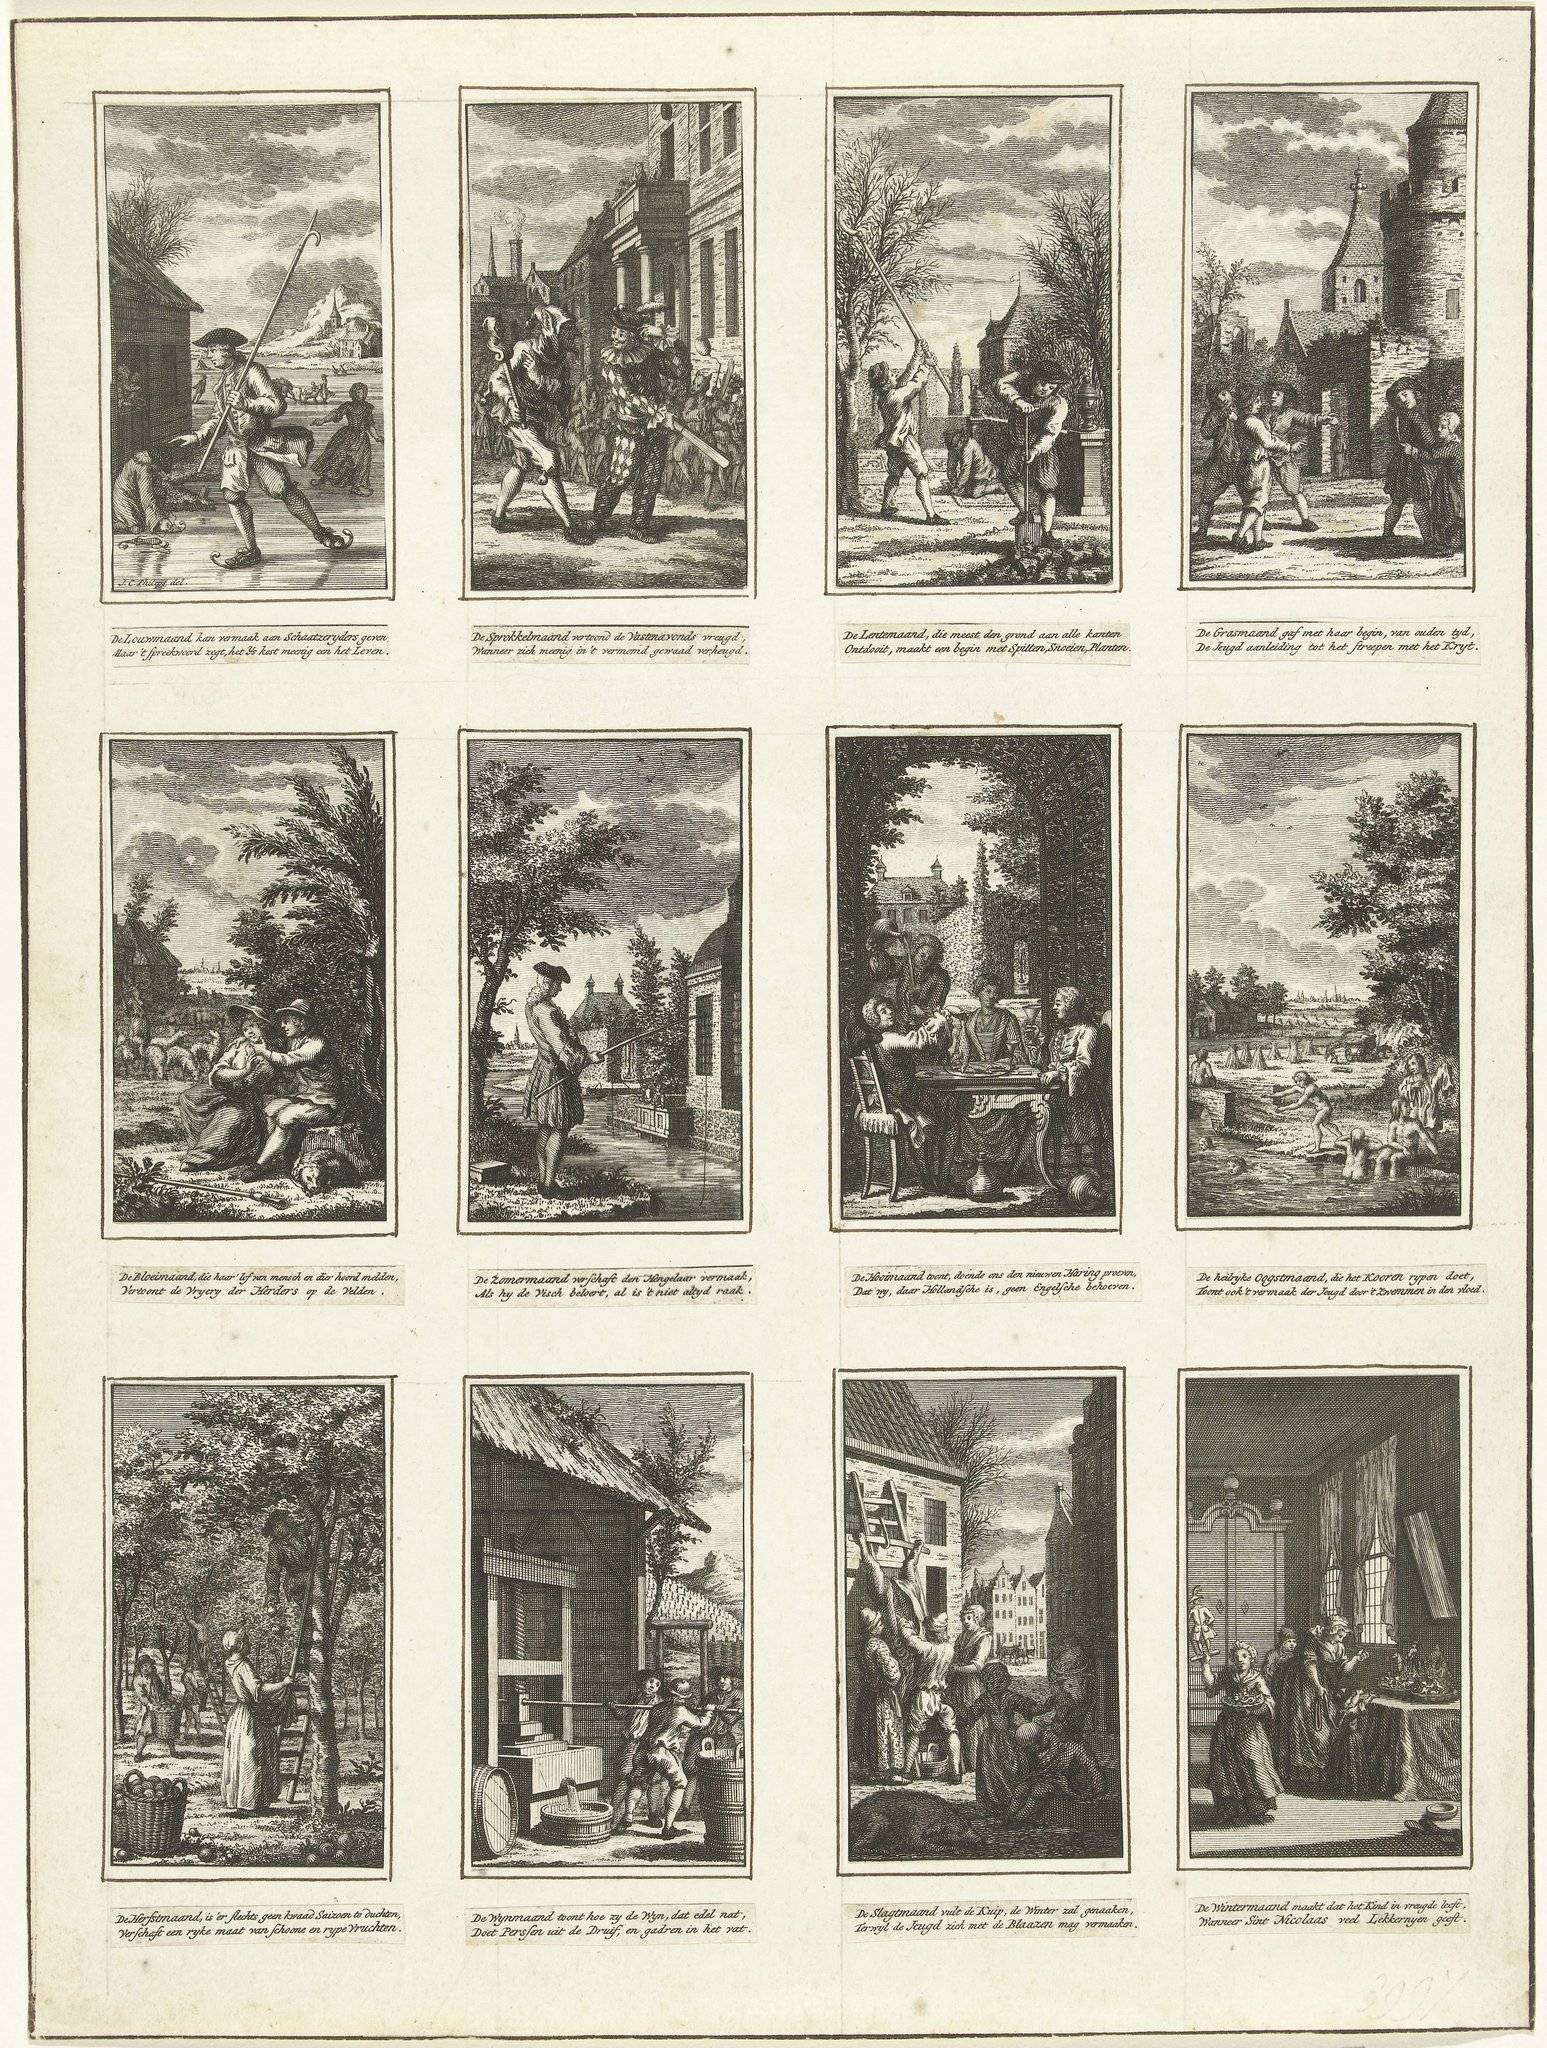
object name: print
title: Hollandse vermaken in de twaalf maanden, ca. 1750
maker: jan caspar philips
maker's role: draughtsman, print maker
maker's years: 1700-1775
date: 1740-1760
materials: paper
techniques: etching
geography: northern netherlands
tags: the twelve months represented by scenes showing human activities, usually in a landscape; so-called 'labours of the months'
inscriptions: collector's mark: Lugt 2228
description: Blad waarop twaalf uitgeknipte prentjes met bijbehorende tweeregelige versjes zijn geplakt. Elke voorstelling van een maand met de daarbij behorend vorm van vermaak, ca. 1750.